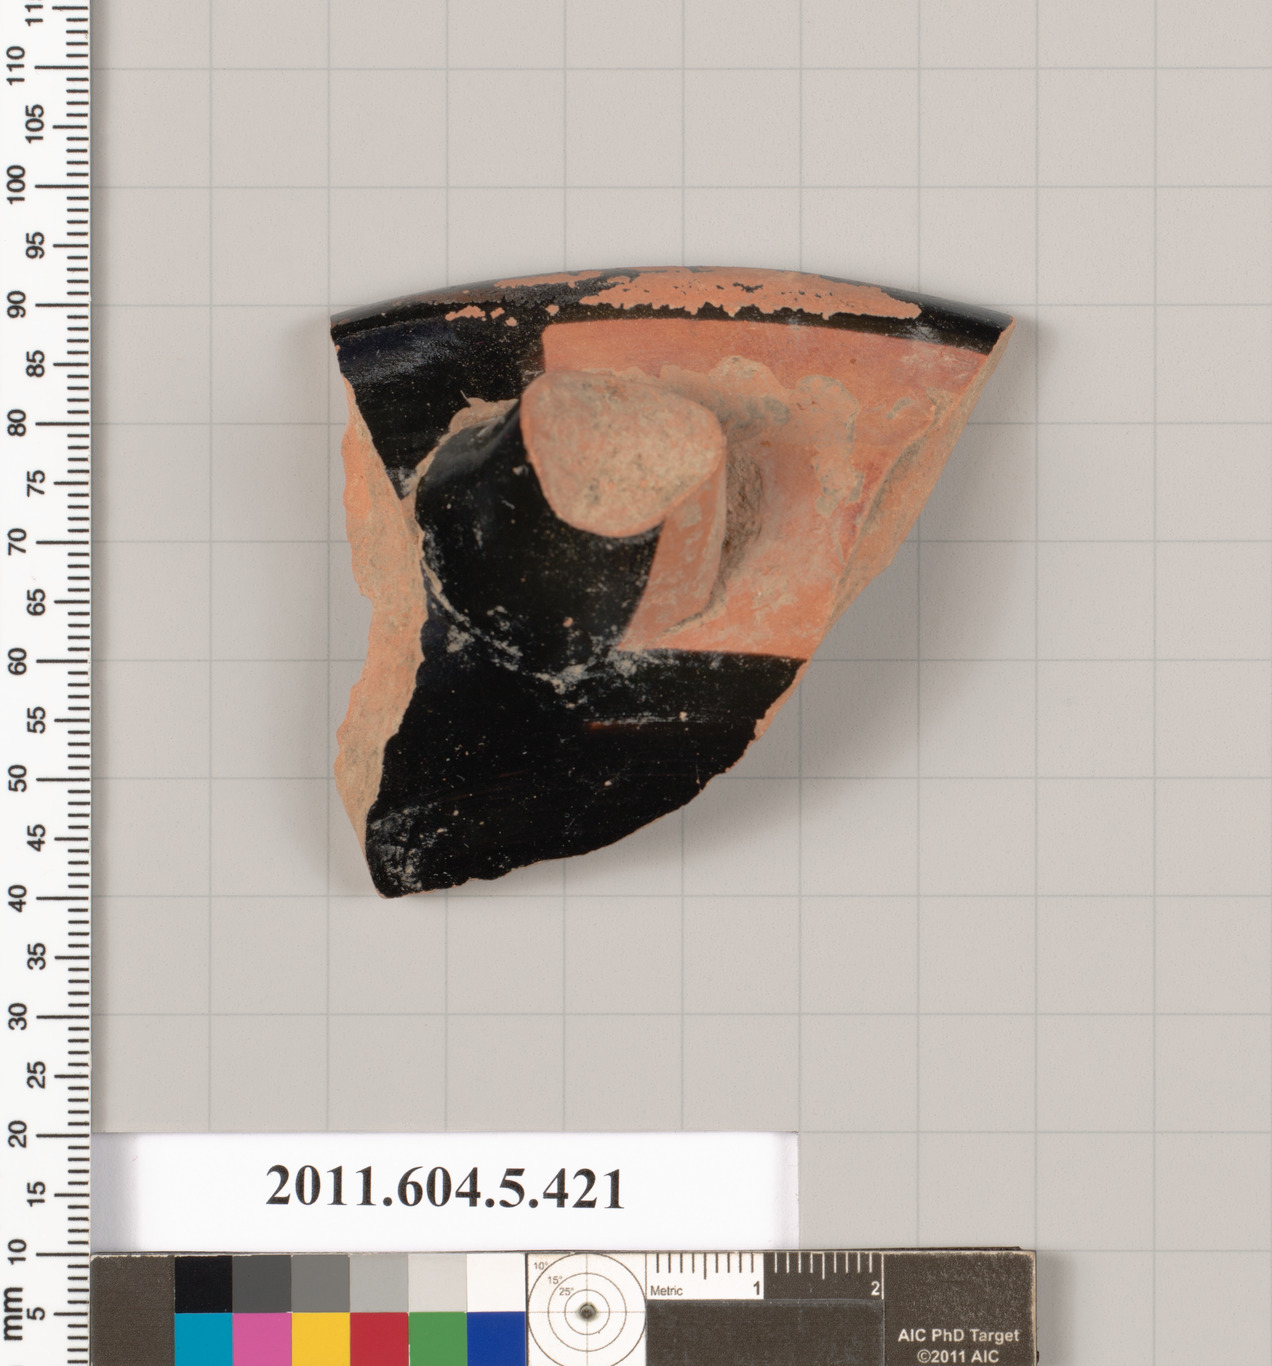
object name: kylix fragment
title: Terracotta rim fragment of a kylix (drinking cup)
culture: greek, attic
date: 500-401 BCE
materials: terracotta